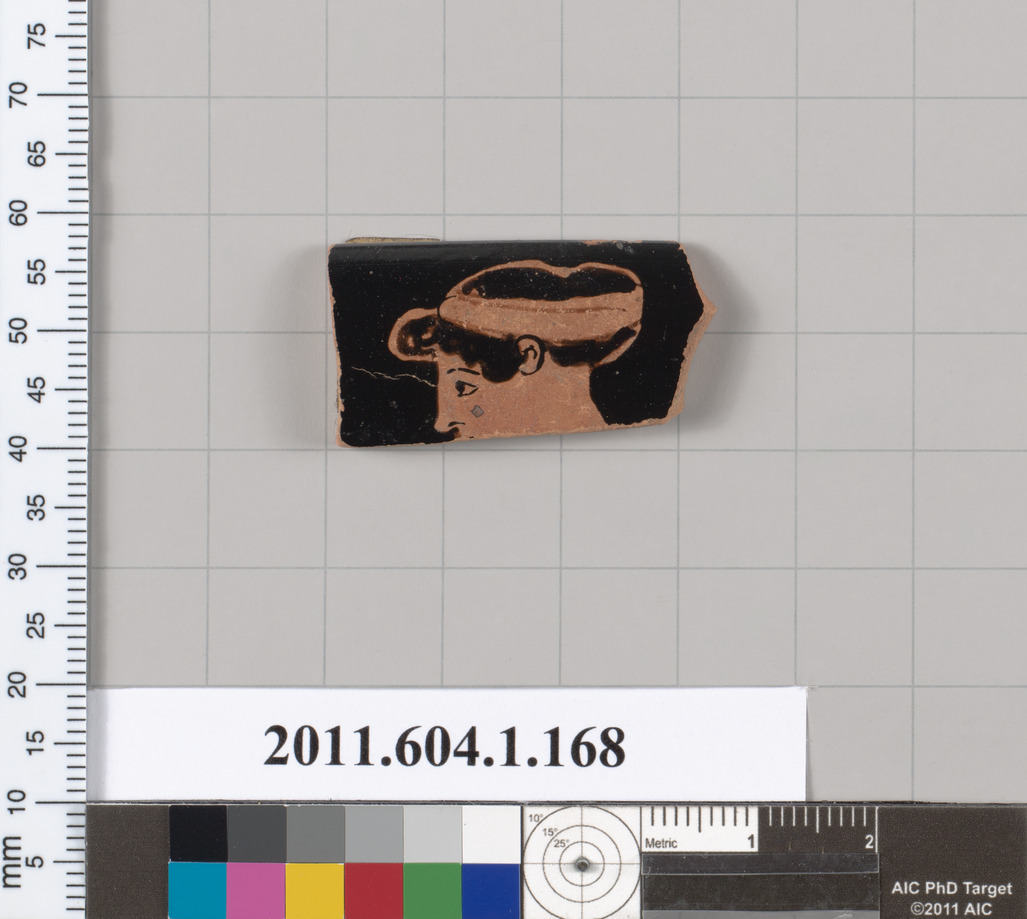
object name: kylix fragment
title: Terracotta rim fragment of a kylix (drinking cup)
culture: greek, attic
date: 470-450 BCE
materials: terracotta